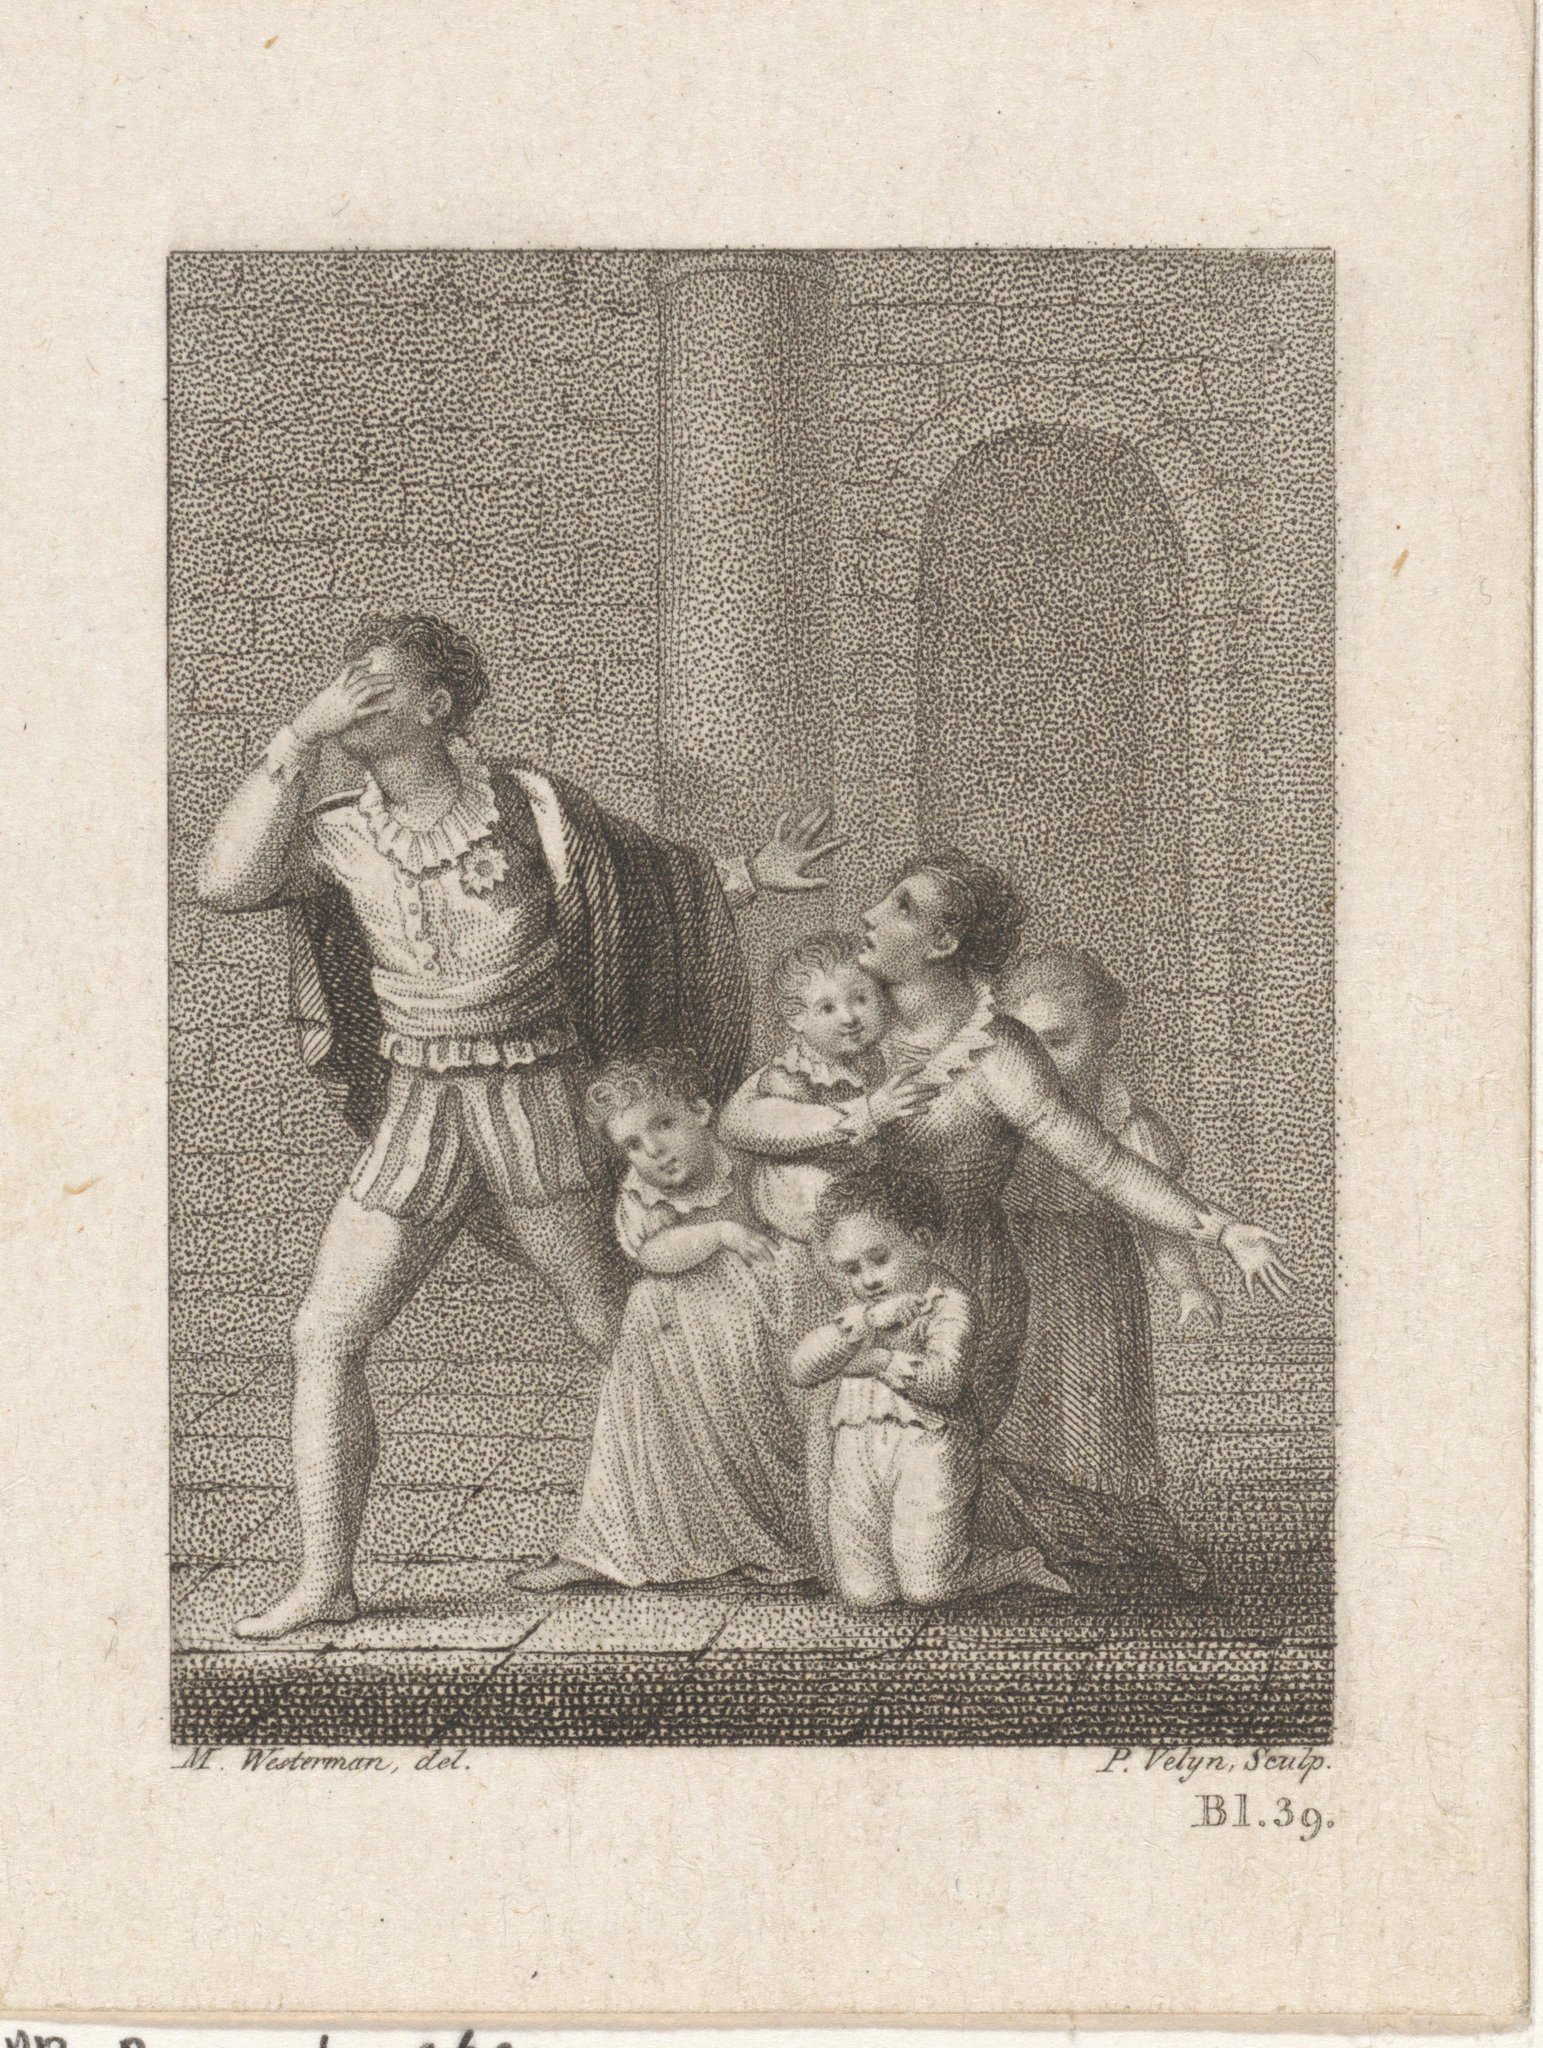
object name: print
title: Man met zijn hand voor het gezicht bij een vrouw met vier kinderen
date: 1818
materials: paper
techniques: etching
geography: netherlands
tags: mother with son(s) and daughter(s) (mother-love), kneeling figure - aa - female human figure, arm stretched sidewards, hand(s) towards the eye(s), mother and baby or young child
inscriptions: collector's mark: Lugt 2228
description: Een man maakt een afwijzend gebaar en heeft zijn hand voor zijn gezicht, bij een geknielde vrouw die omringd is met vier kinderen. Haar linkerhand heeft zij vragend uitgestoken. Rechtsonder: bl. 39.